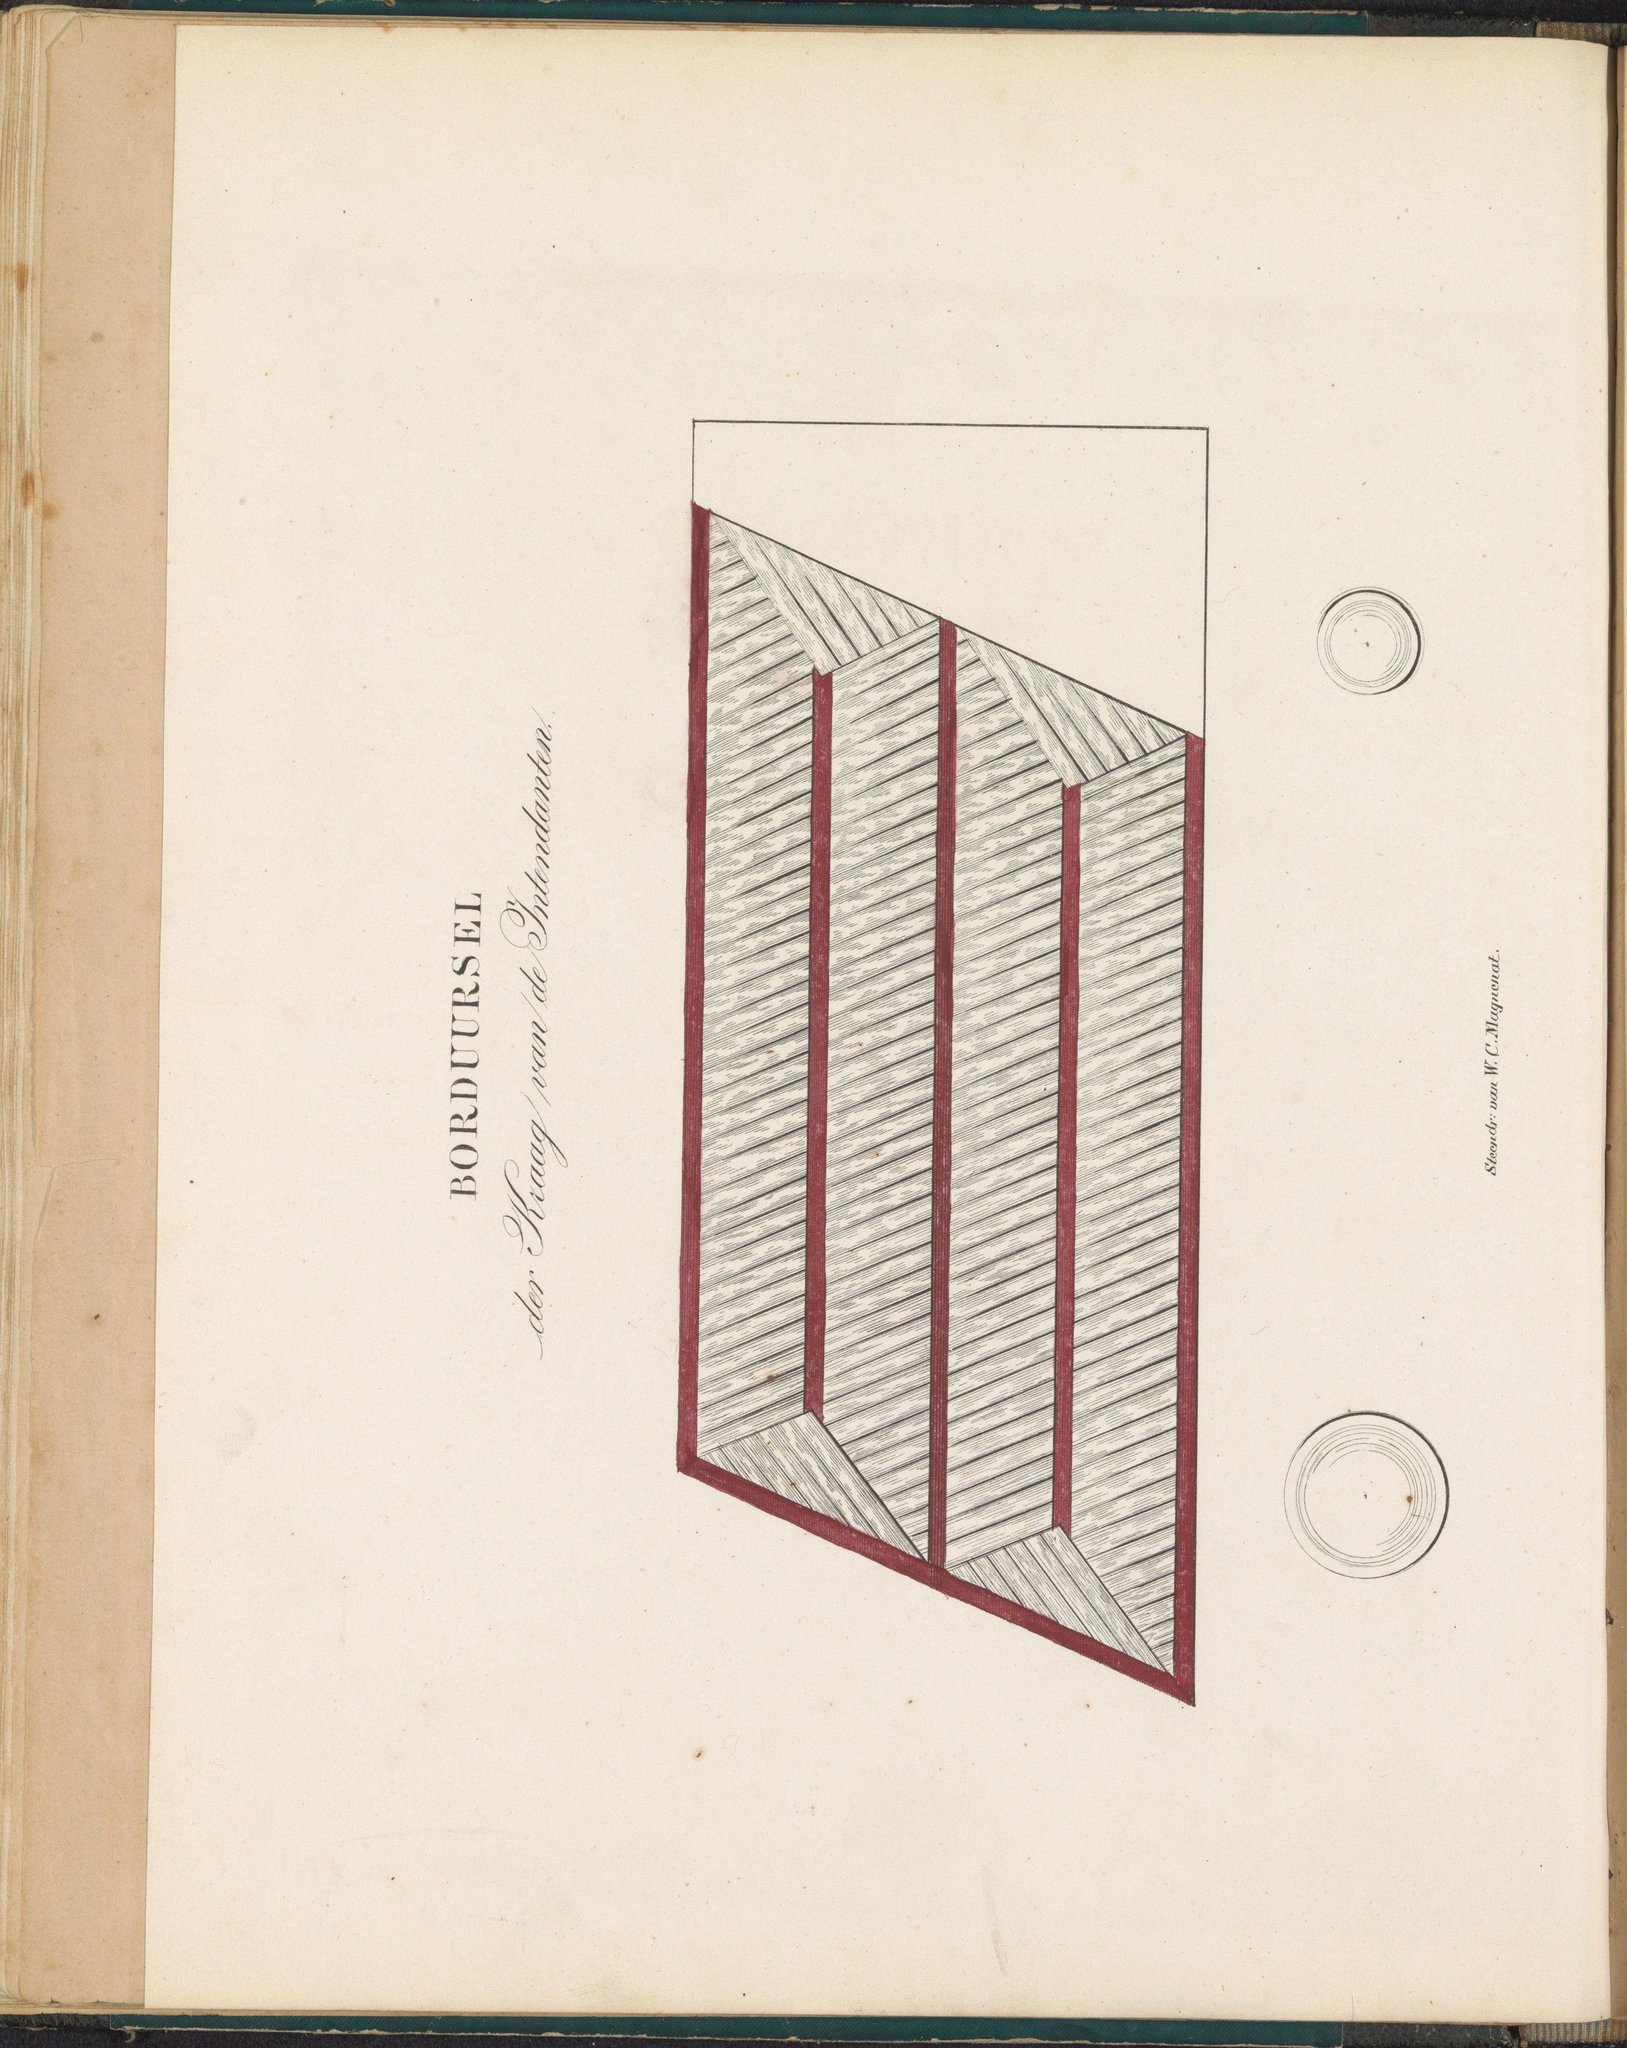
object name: print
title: Borduursel der Kraag van de Intendanten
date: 1845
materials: paper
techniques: hand coloring, lithograph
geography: amsterdam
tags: (military) uniforms, netherlands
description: Borduursel op het uniform van de militaire intendanten. Illustratie in een boek uit 1845 over de uniformen en kledingstukken van de Nederlandse land-, zeemacht en schutterijen in Nederland en in de overzeese gebiedsdelen.